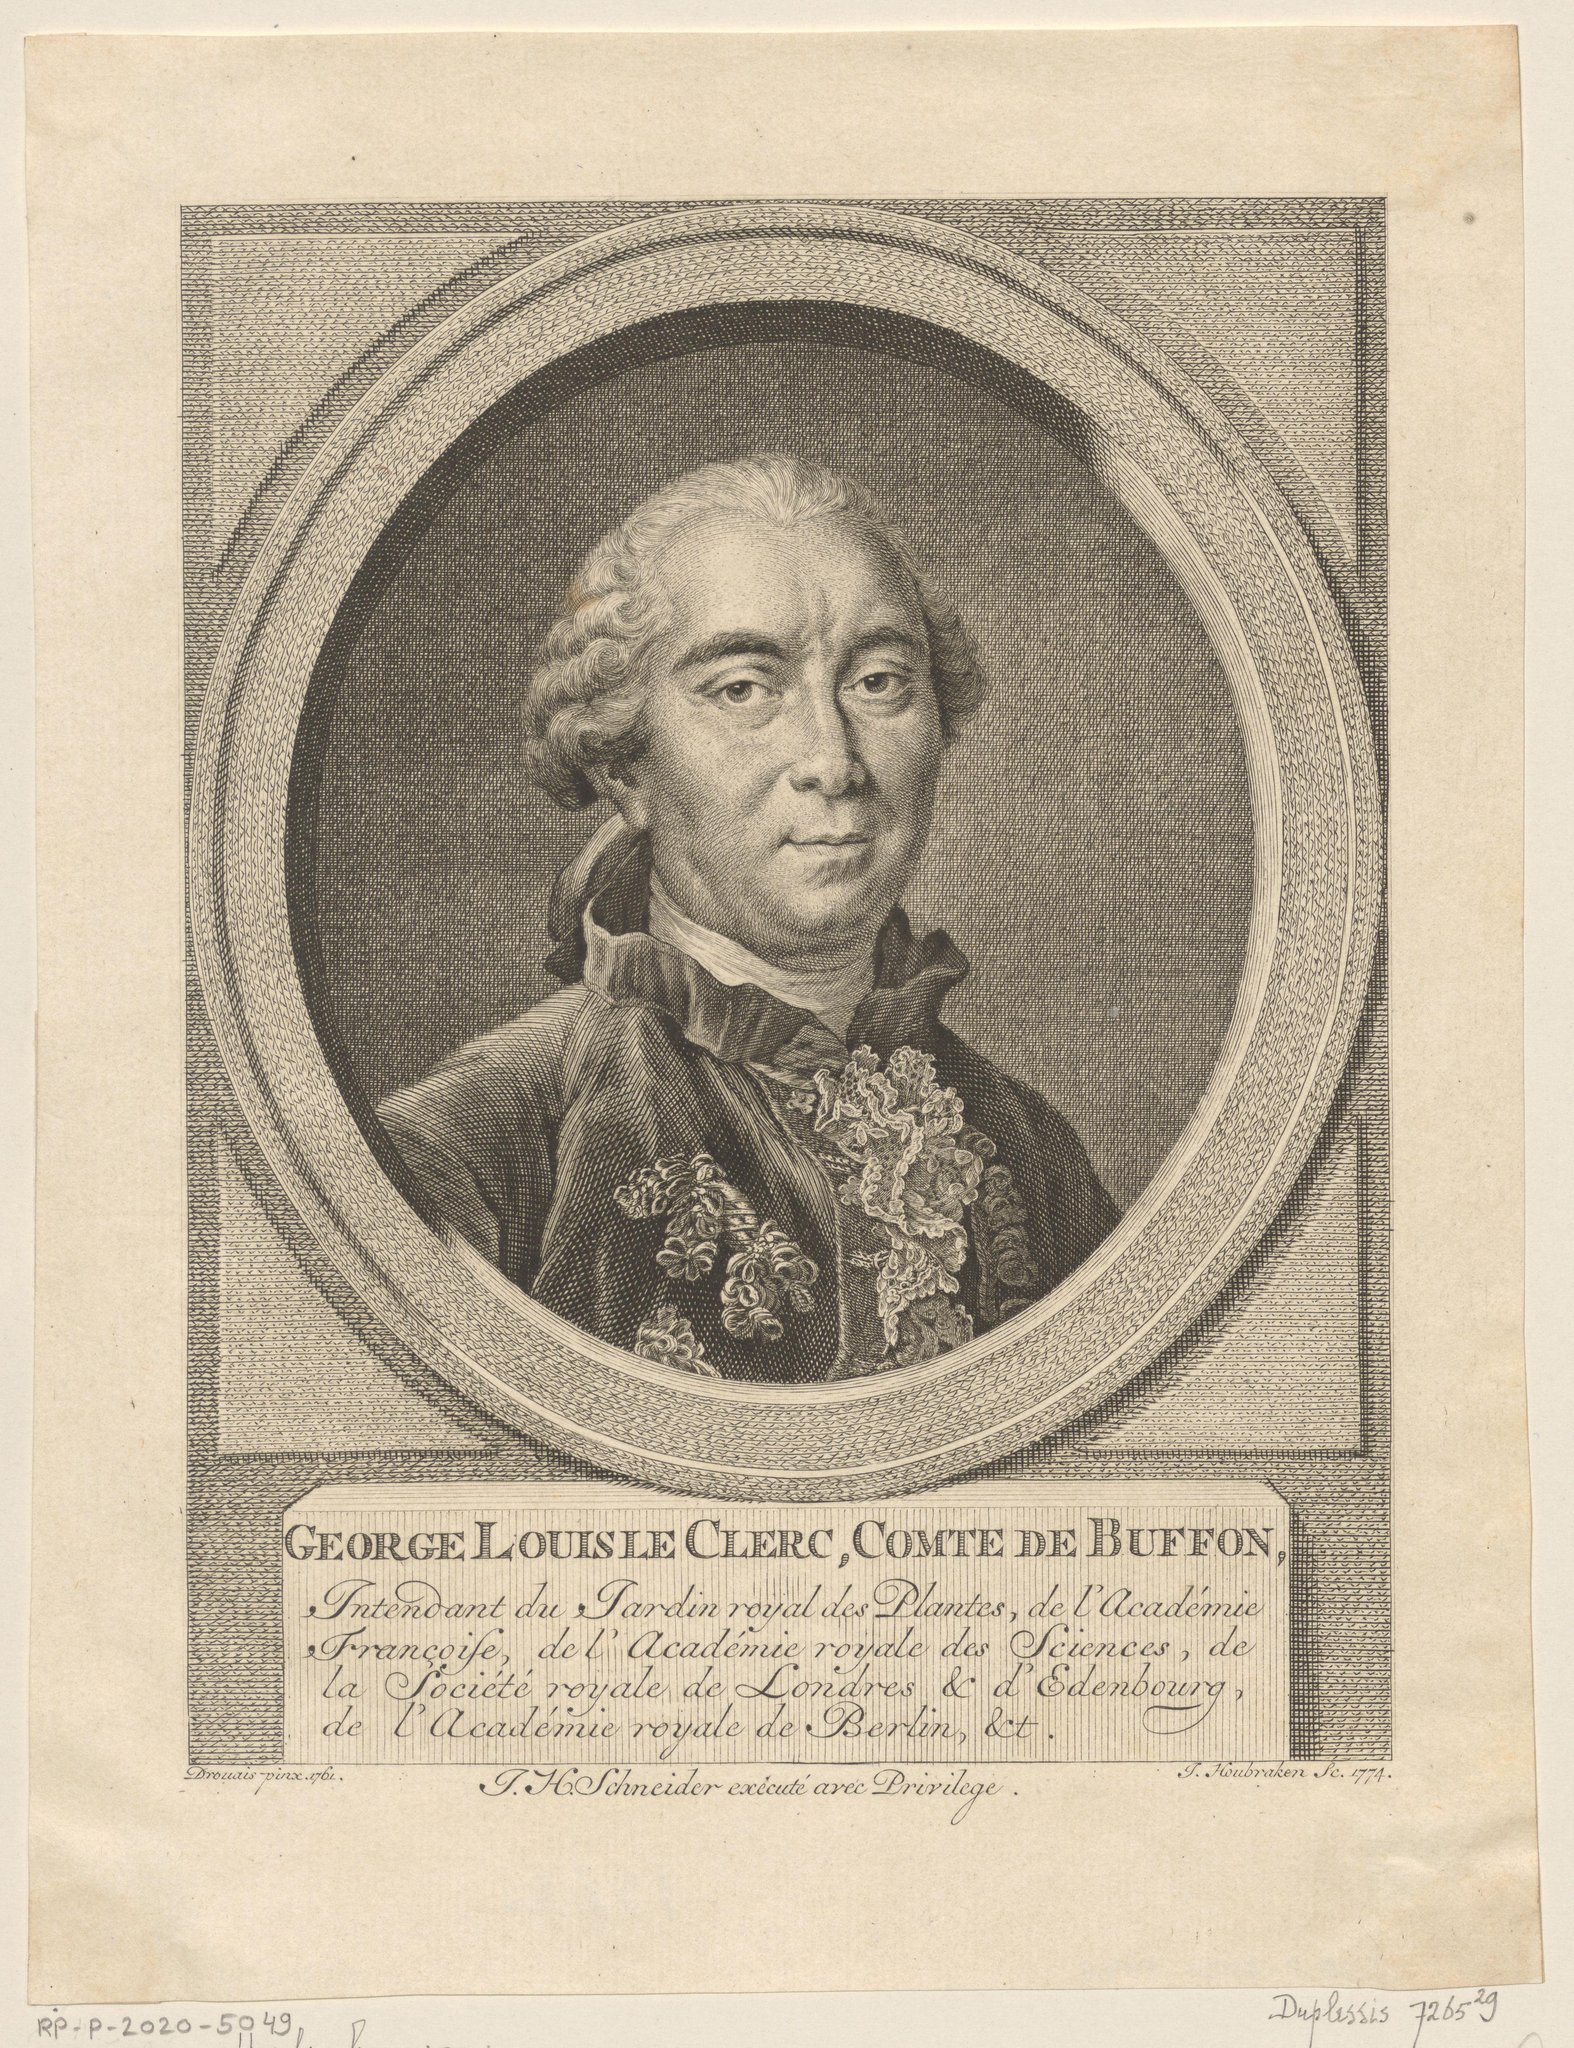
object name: print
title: Portret van Georges-Louis Leclerc de Buffon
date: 1774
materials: paper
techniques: engraving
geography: amsterdam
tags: paris, georges-louis leclerc de buffon (graaf), scholar, philosopher, historical persons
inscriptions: date